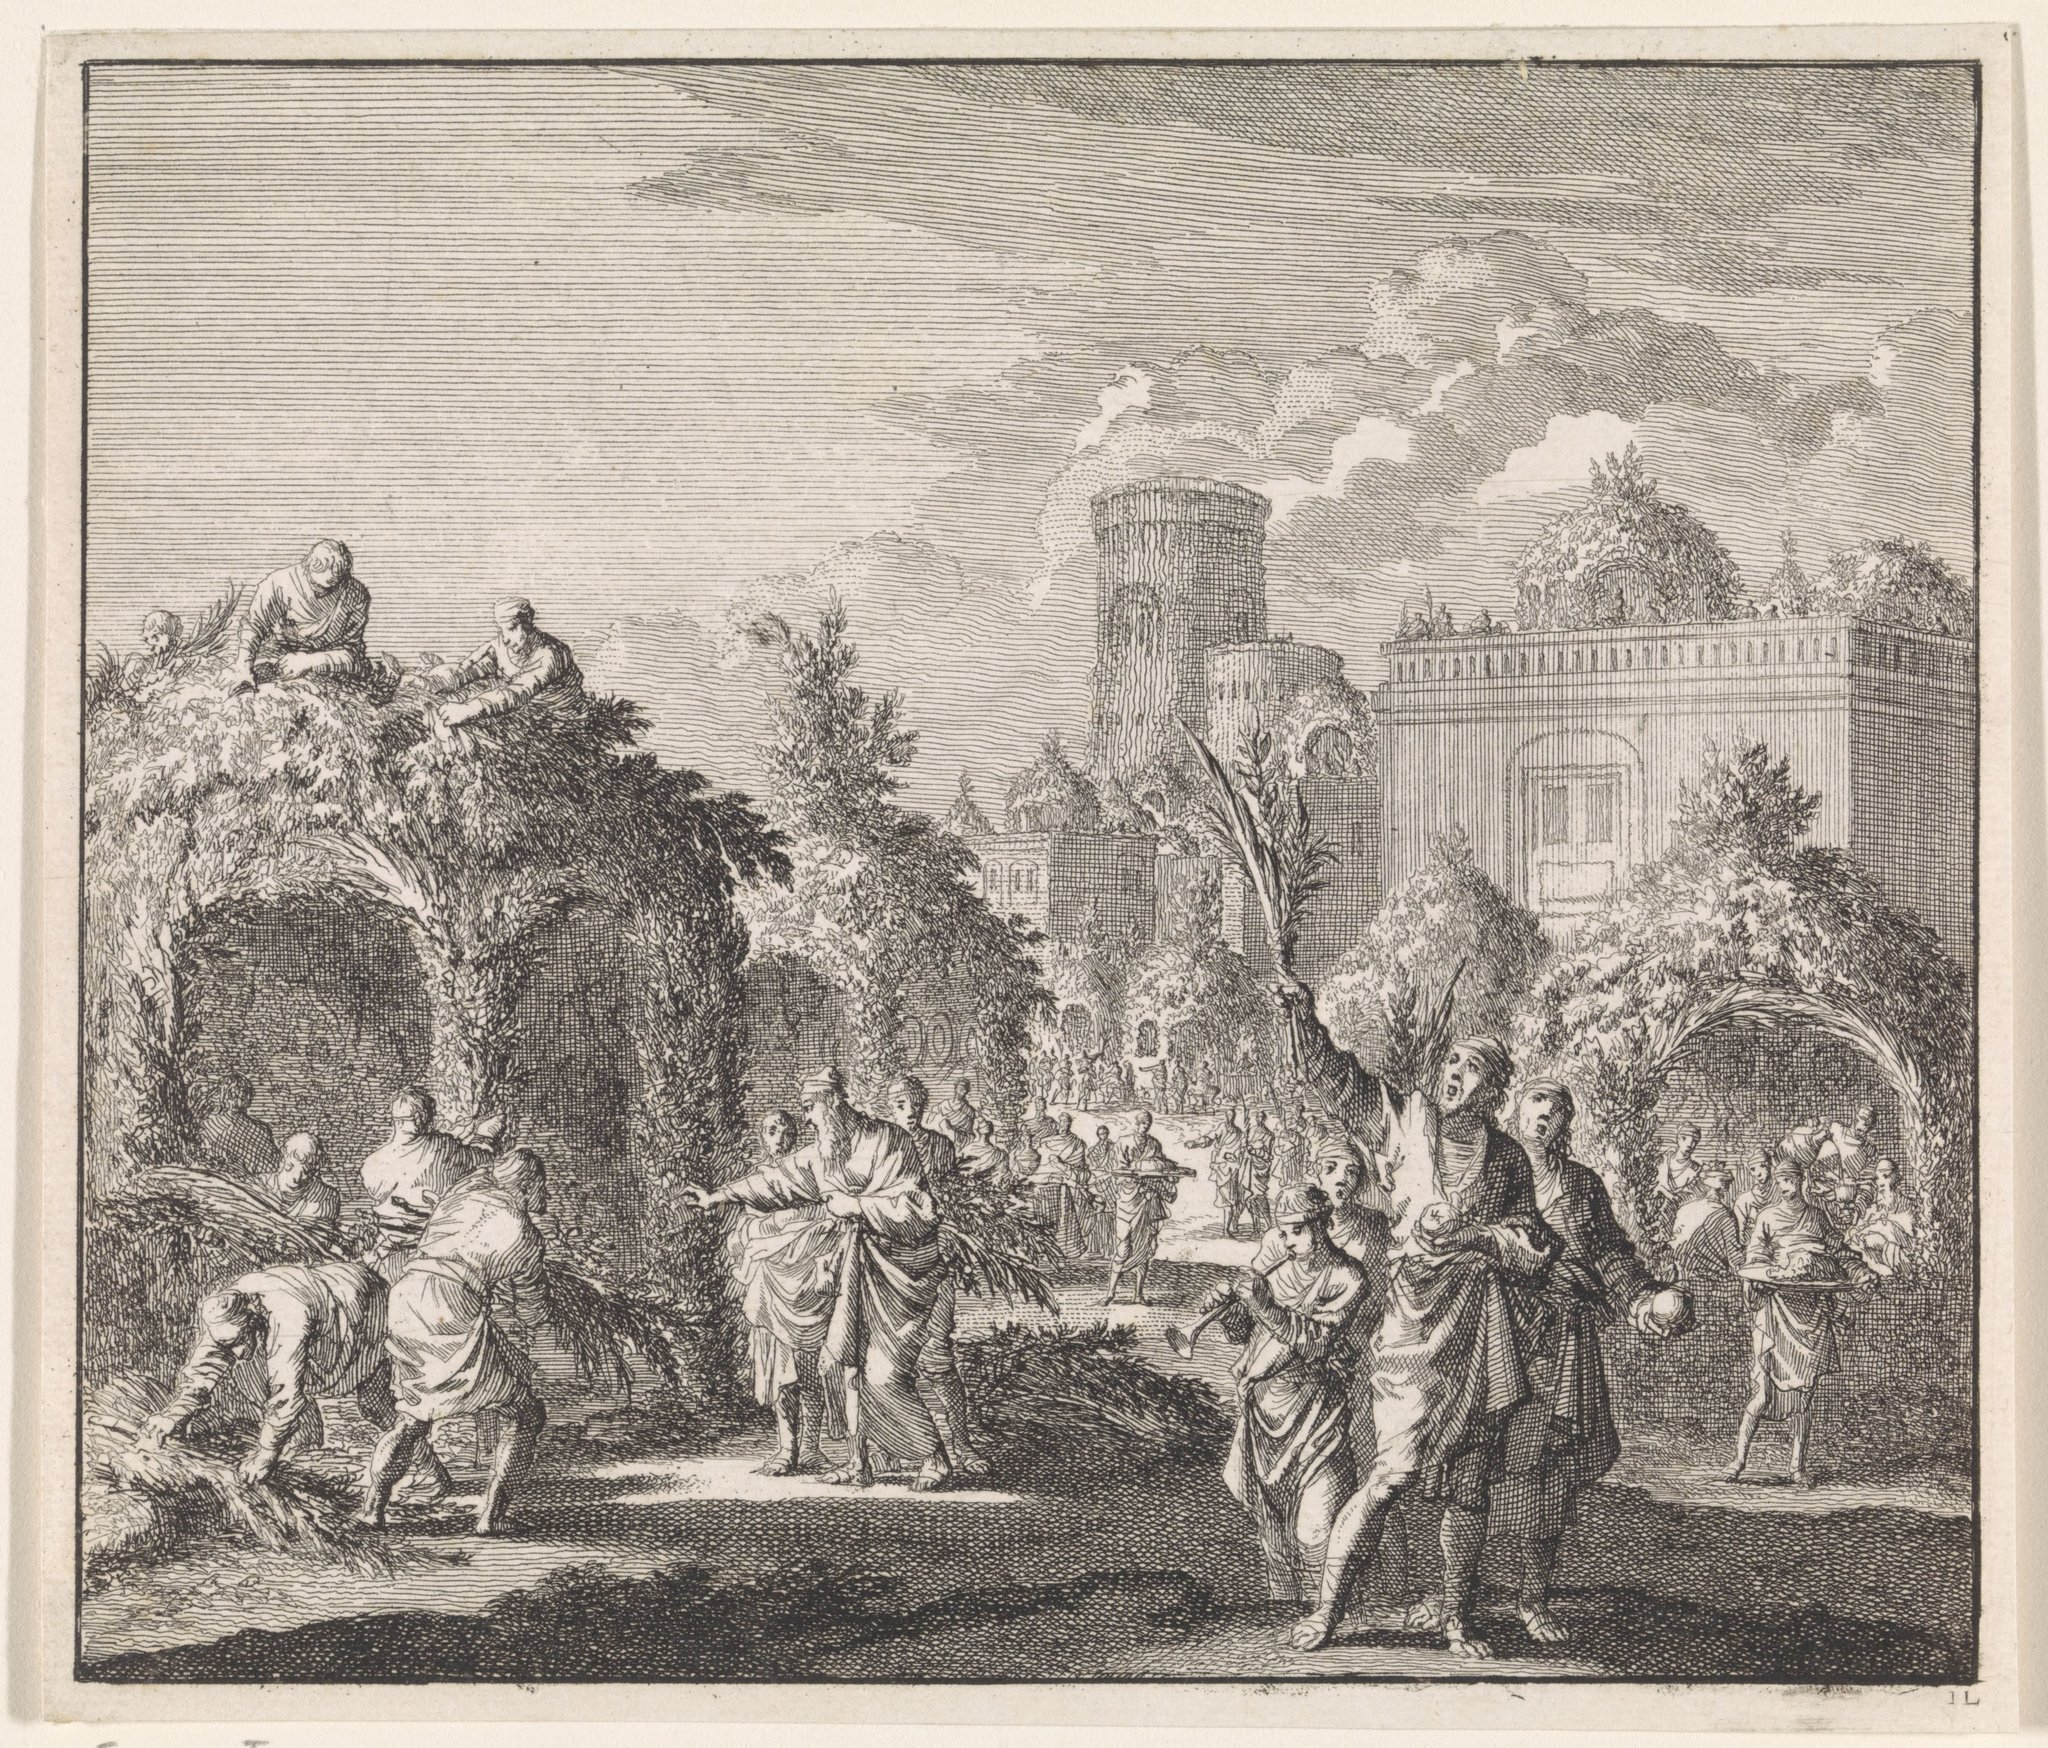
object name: print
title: Loofhuttenfeest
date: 1702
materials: paper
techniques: etching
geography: leiden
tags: 'sukkot', feast of the tabernacles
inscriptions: collector's mark: Lugt 2228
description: Het Joodse volk viert het loofhuttenfeest. In de straten worden loofhutten gebouwd. Op de voorgrond brengt men loofhout aan en wordt er muziek gespeeld. In een van de hutten wordt een maaltijd opgediend.